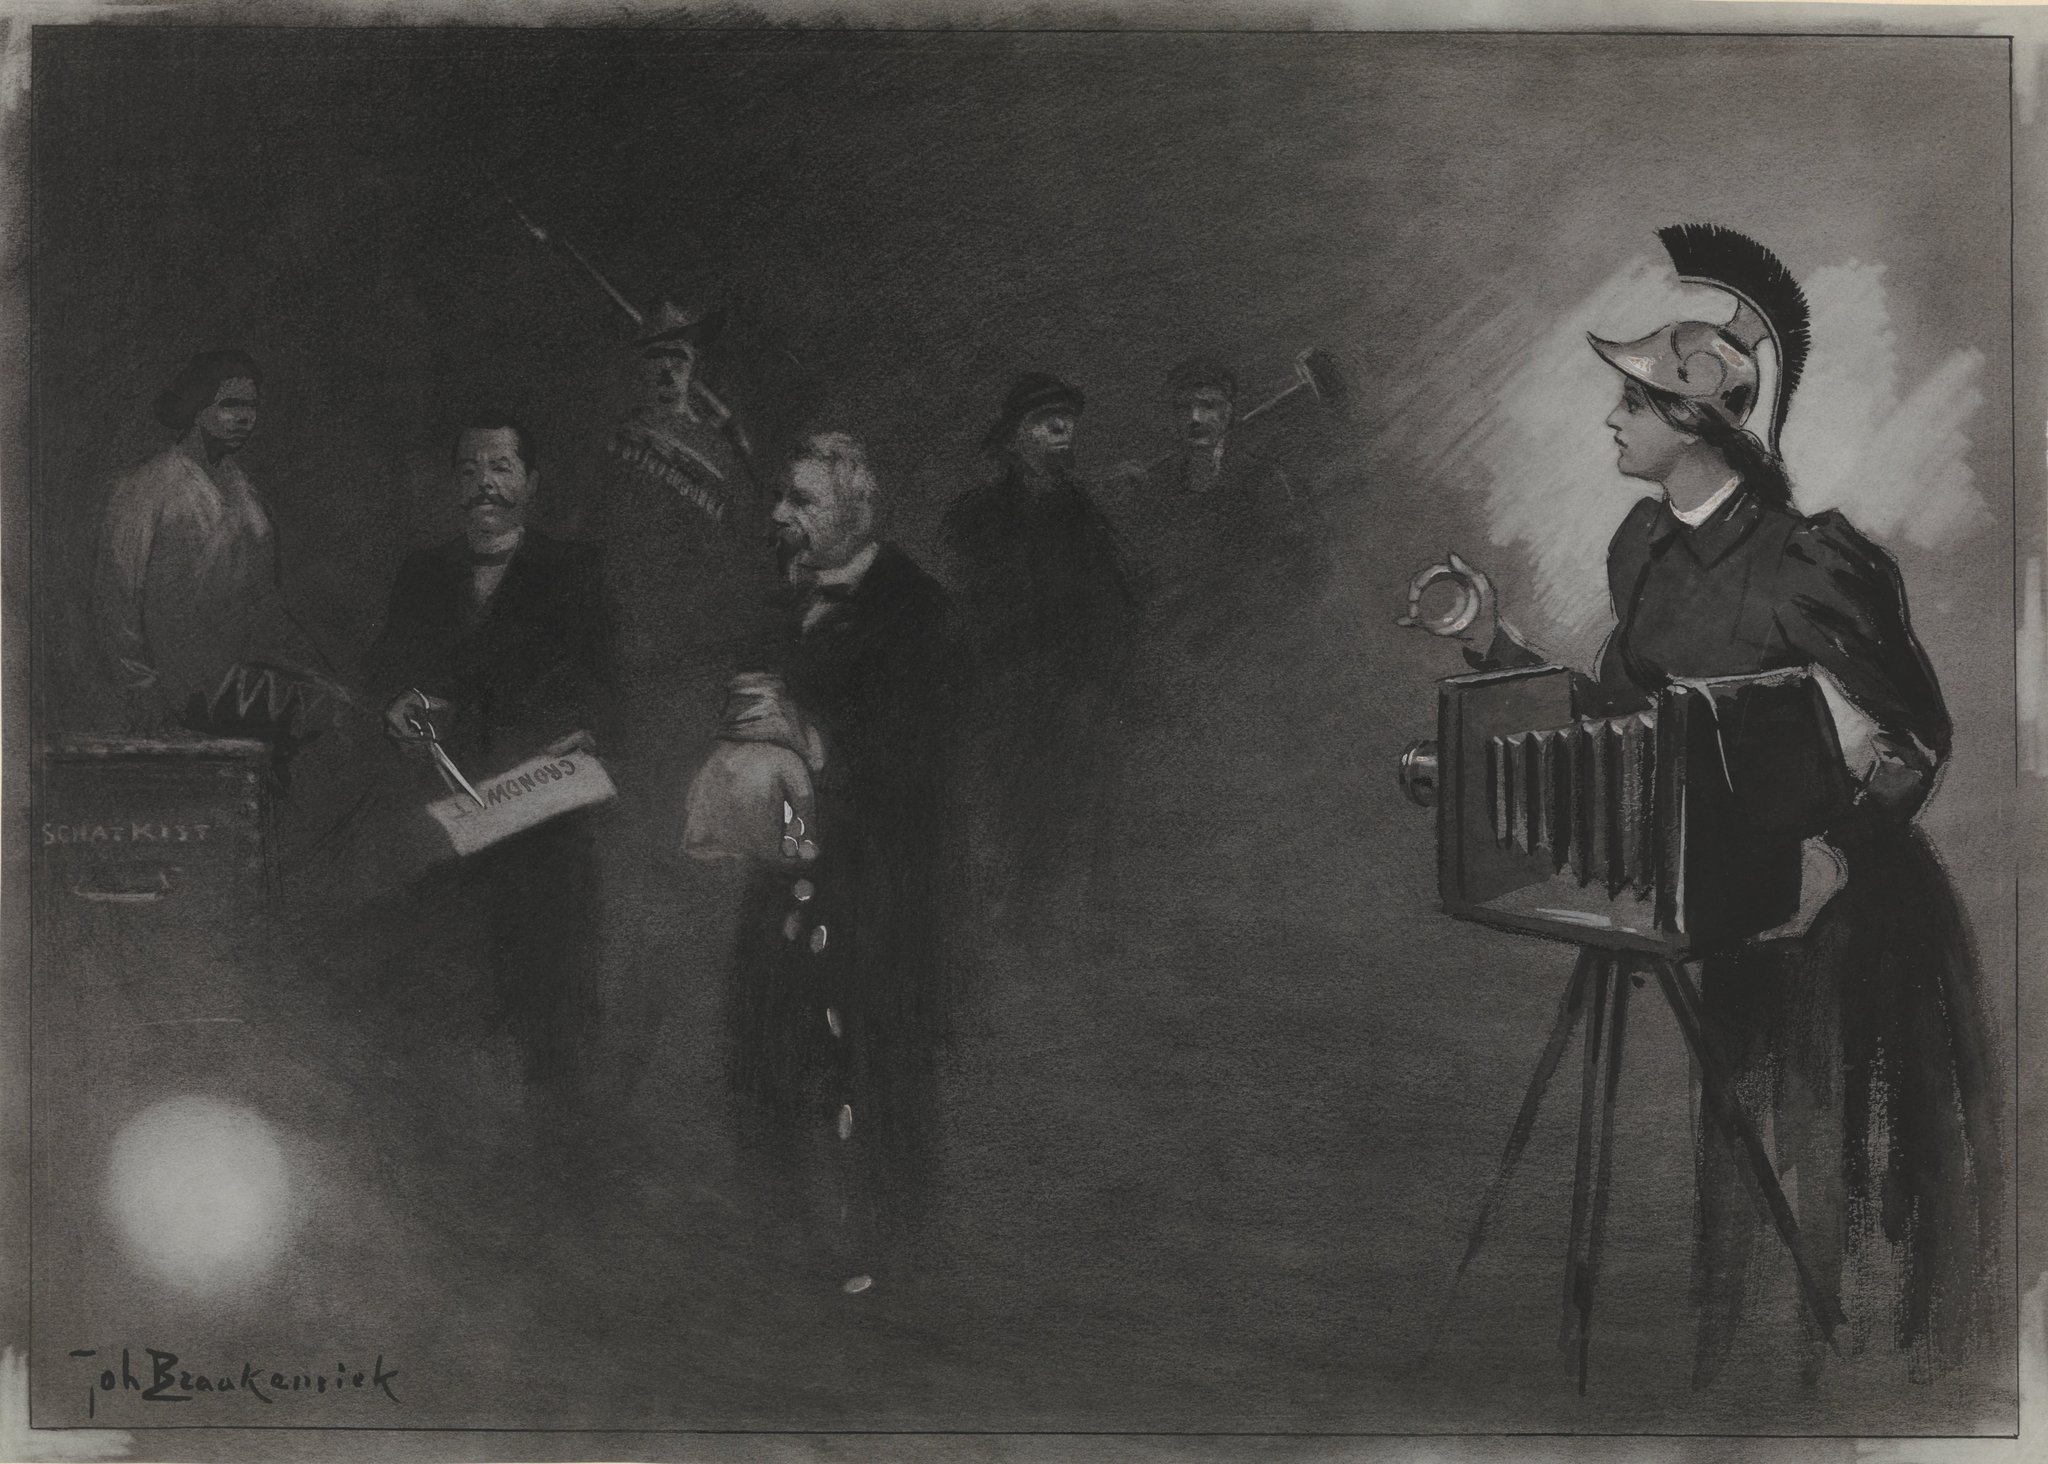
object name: design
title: Ontwerp voor illustratie in De Amsterdammer: De troonrede, 24 sept. 1905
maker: johan braakensiek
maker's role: draughtsman, print maker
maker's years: 1858-1940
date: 1905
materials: chalk, paint, paper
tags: historical events and situations, political caricatures and satires